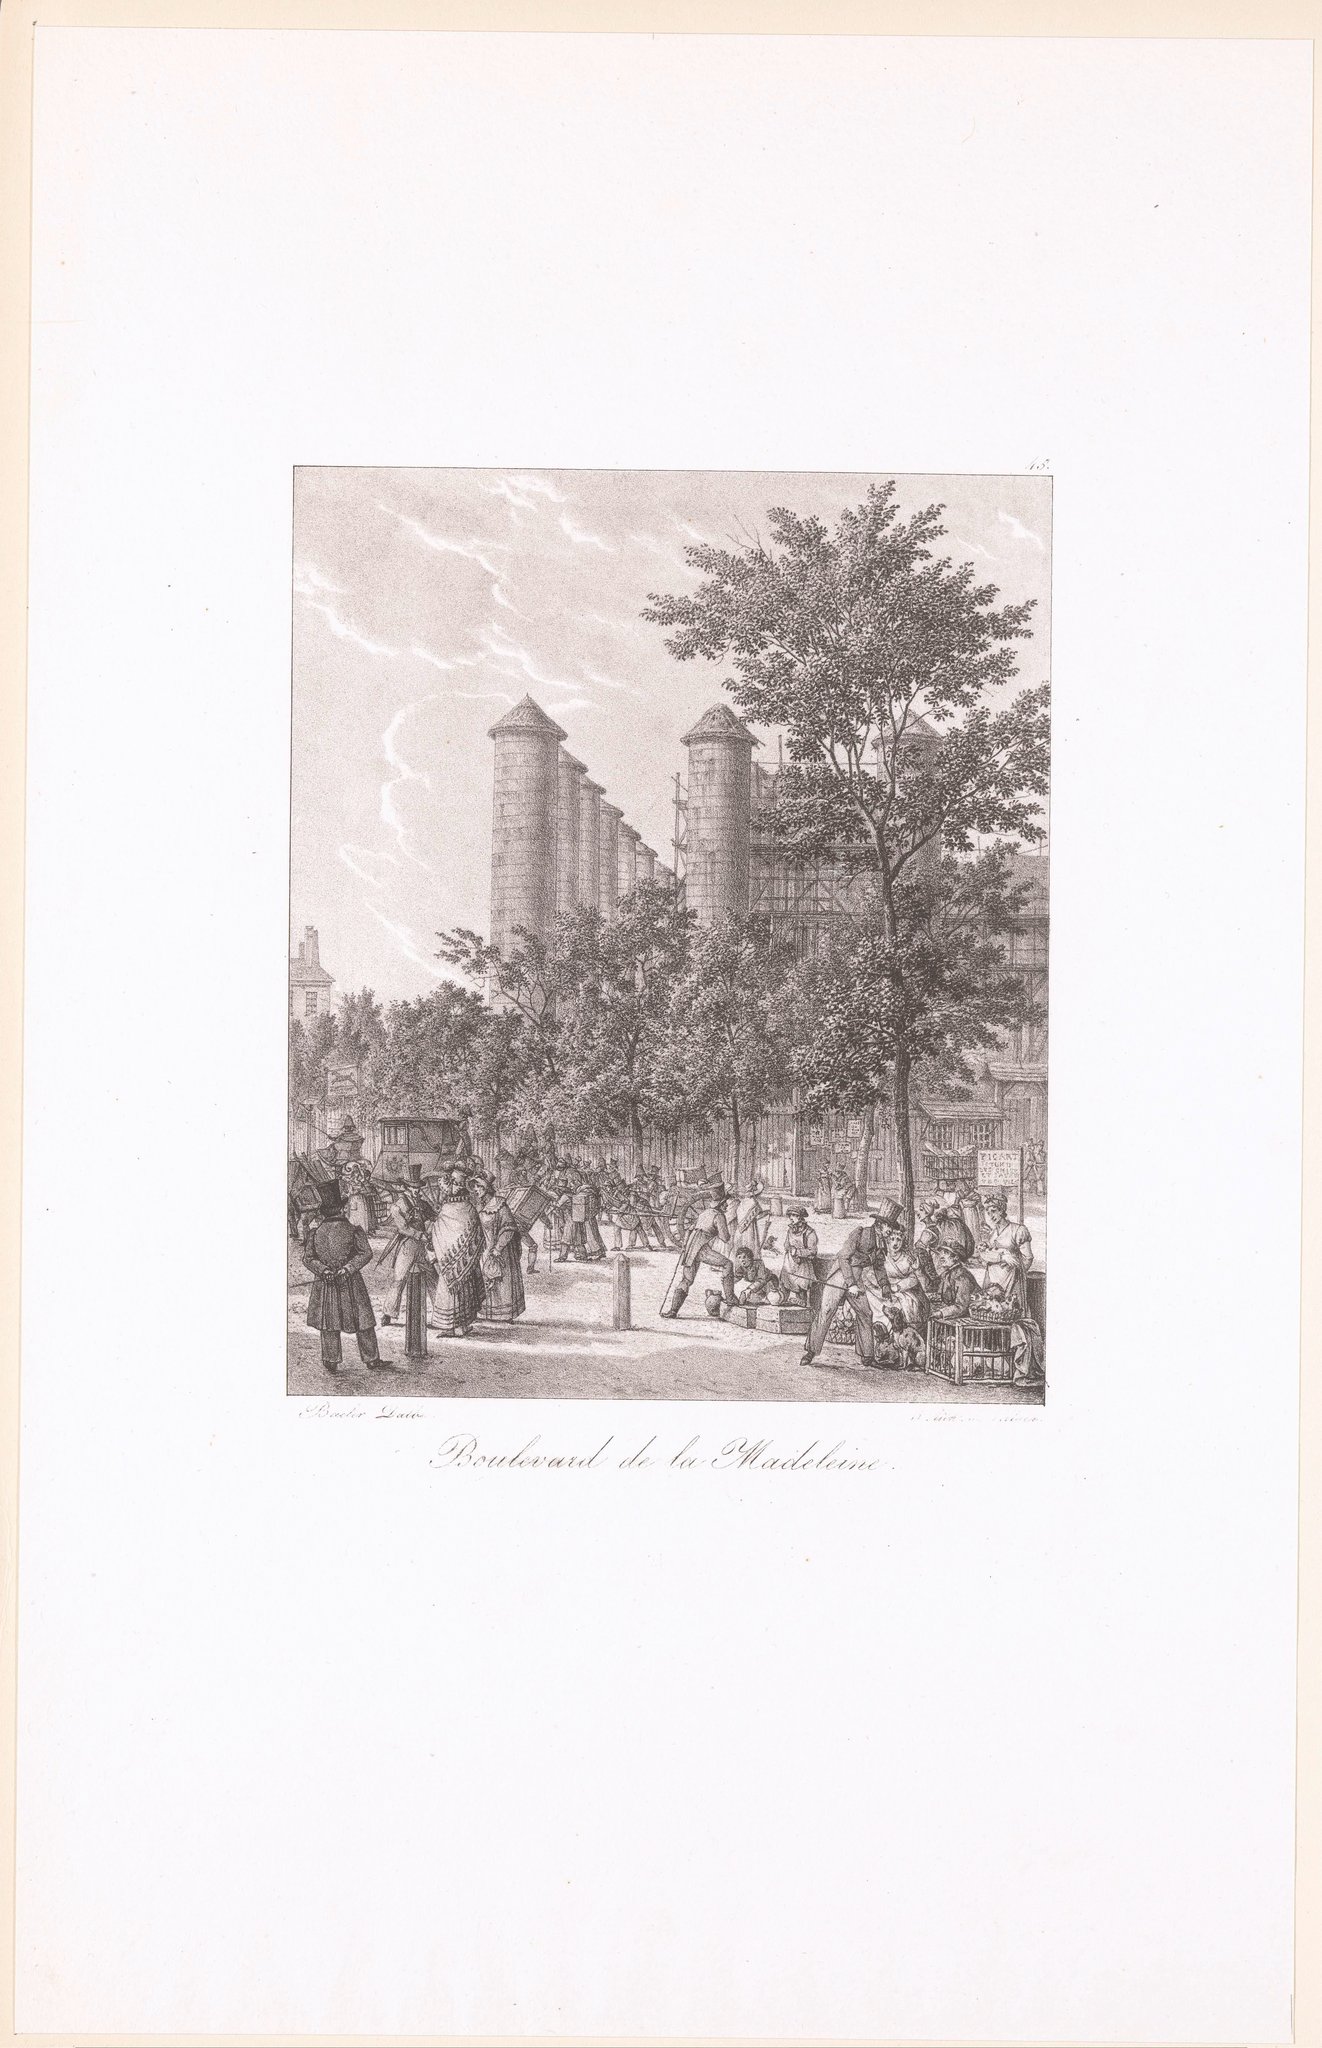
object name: print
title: Pittoreske gezichten op Parijs en omgeving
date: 1822-1824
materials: paper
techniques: lithograph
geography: paris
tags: street-trader, avenue, boulevard in village